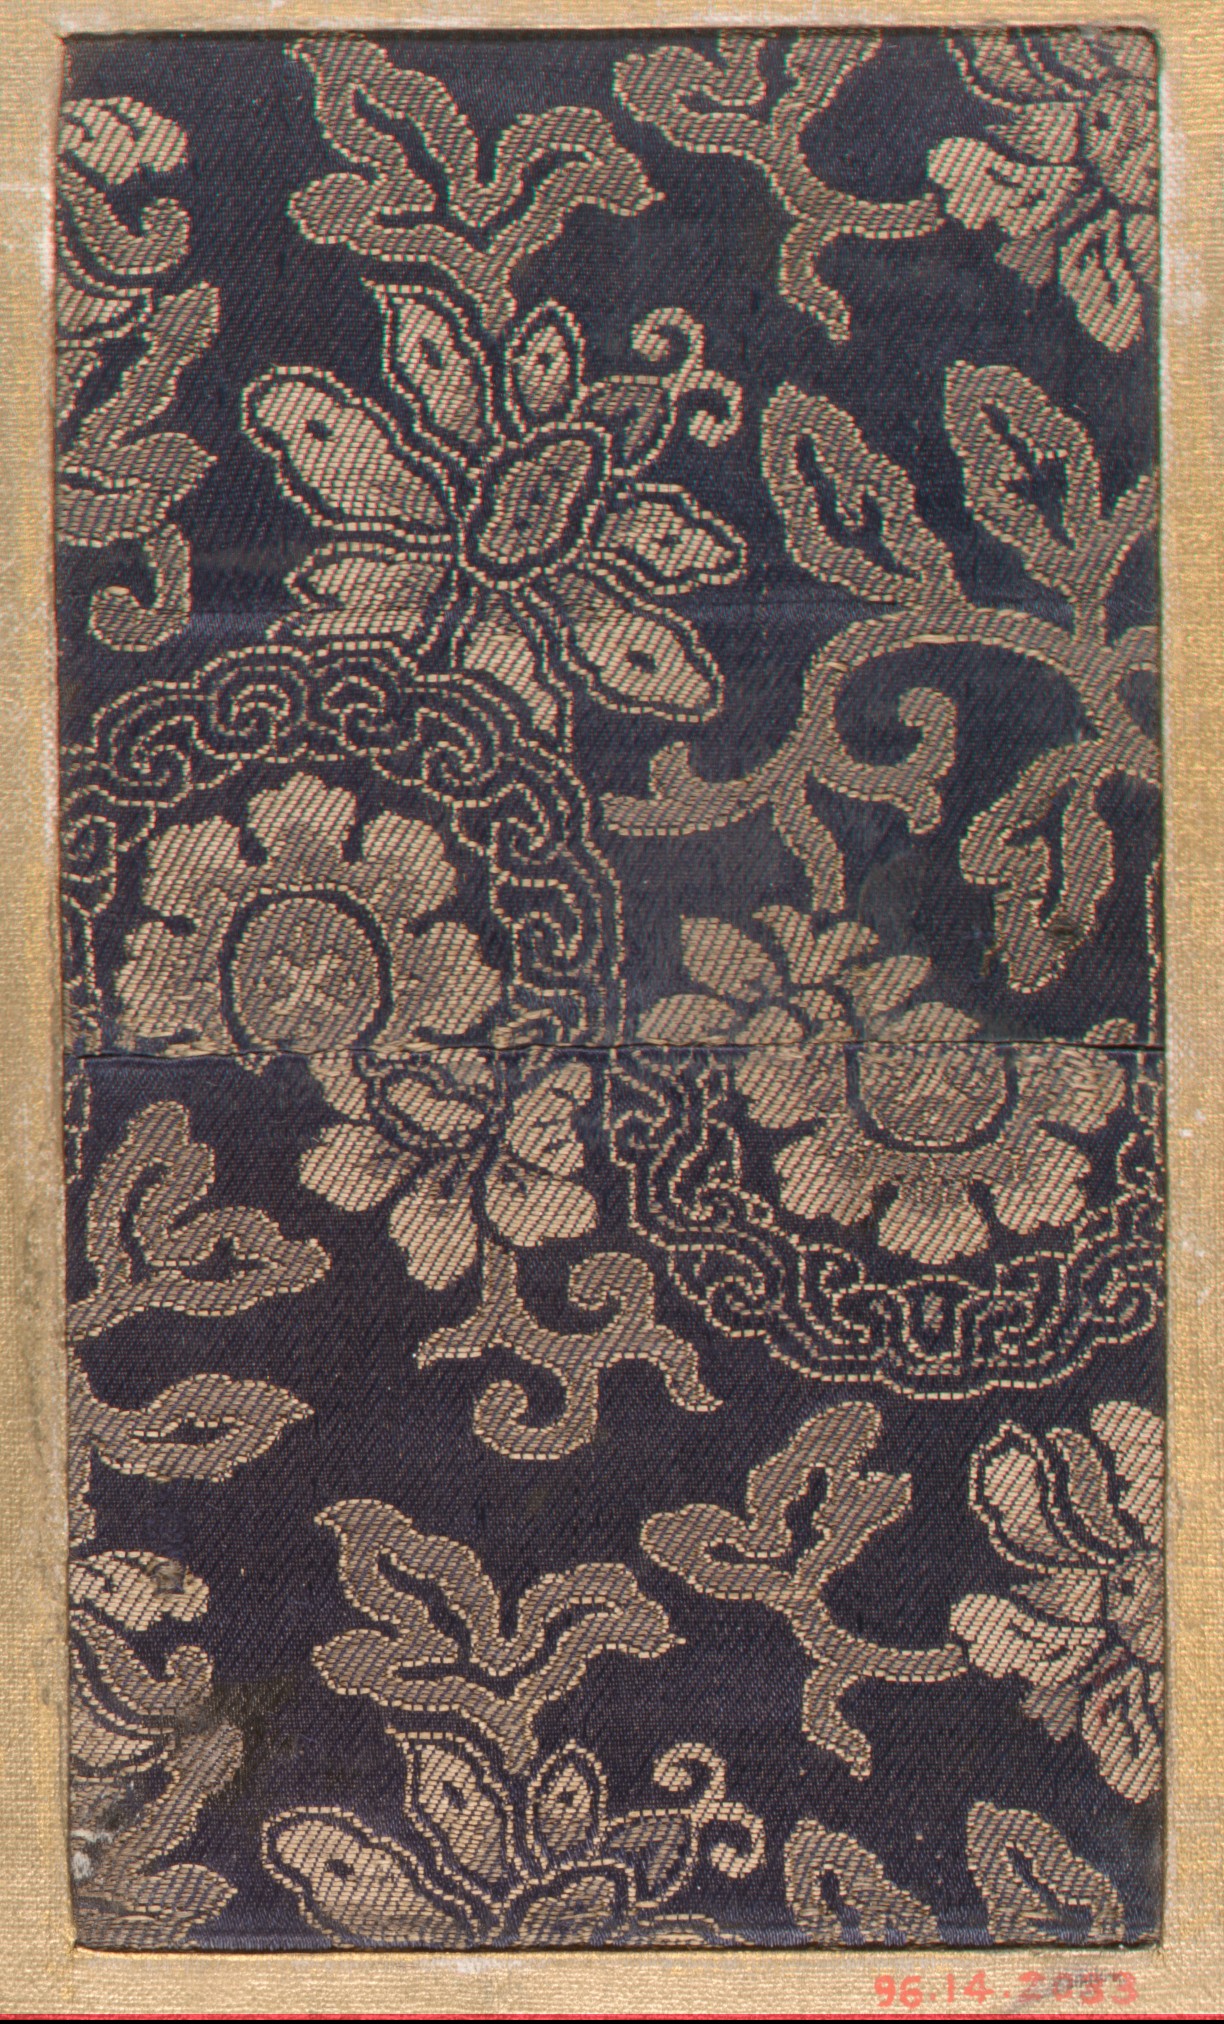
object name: piece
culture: japanese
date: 1701-1900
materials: silk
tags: leaves